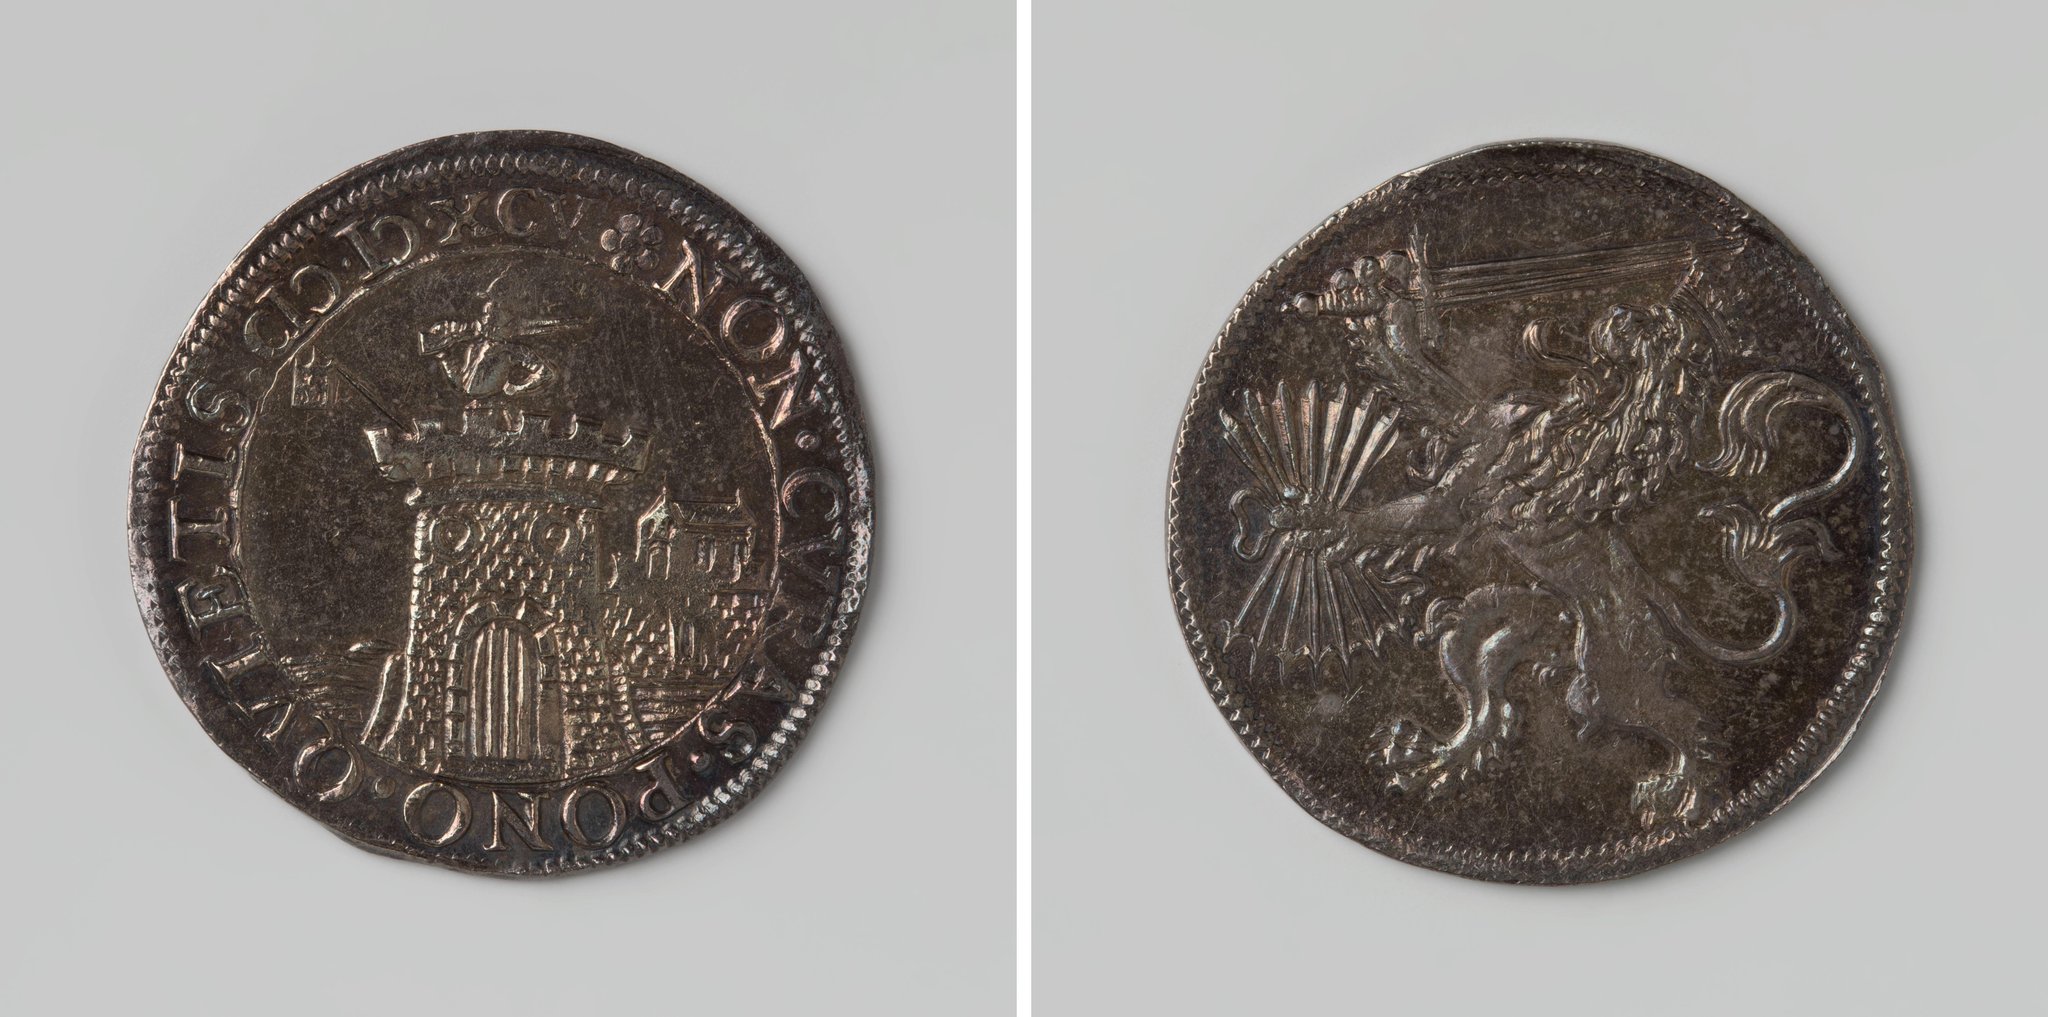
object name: jeton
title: Vredesonderhandelingen te Middelburg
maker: Anonymous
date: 1595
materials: silver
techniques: striking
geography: dordrecht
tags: middelburg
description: Zilveren penning. Voorzijde: soldaat met geweer over zijn schouder, staande op toren binnen omschrift. Keerzijde: gekroonde leeuw met zwaard en bundel van zeven pijlen in klauwen